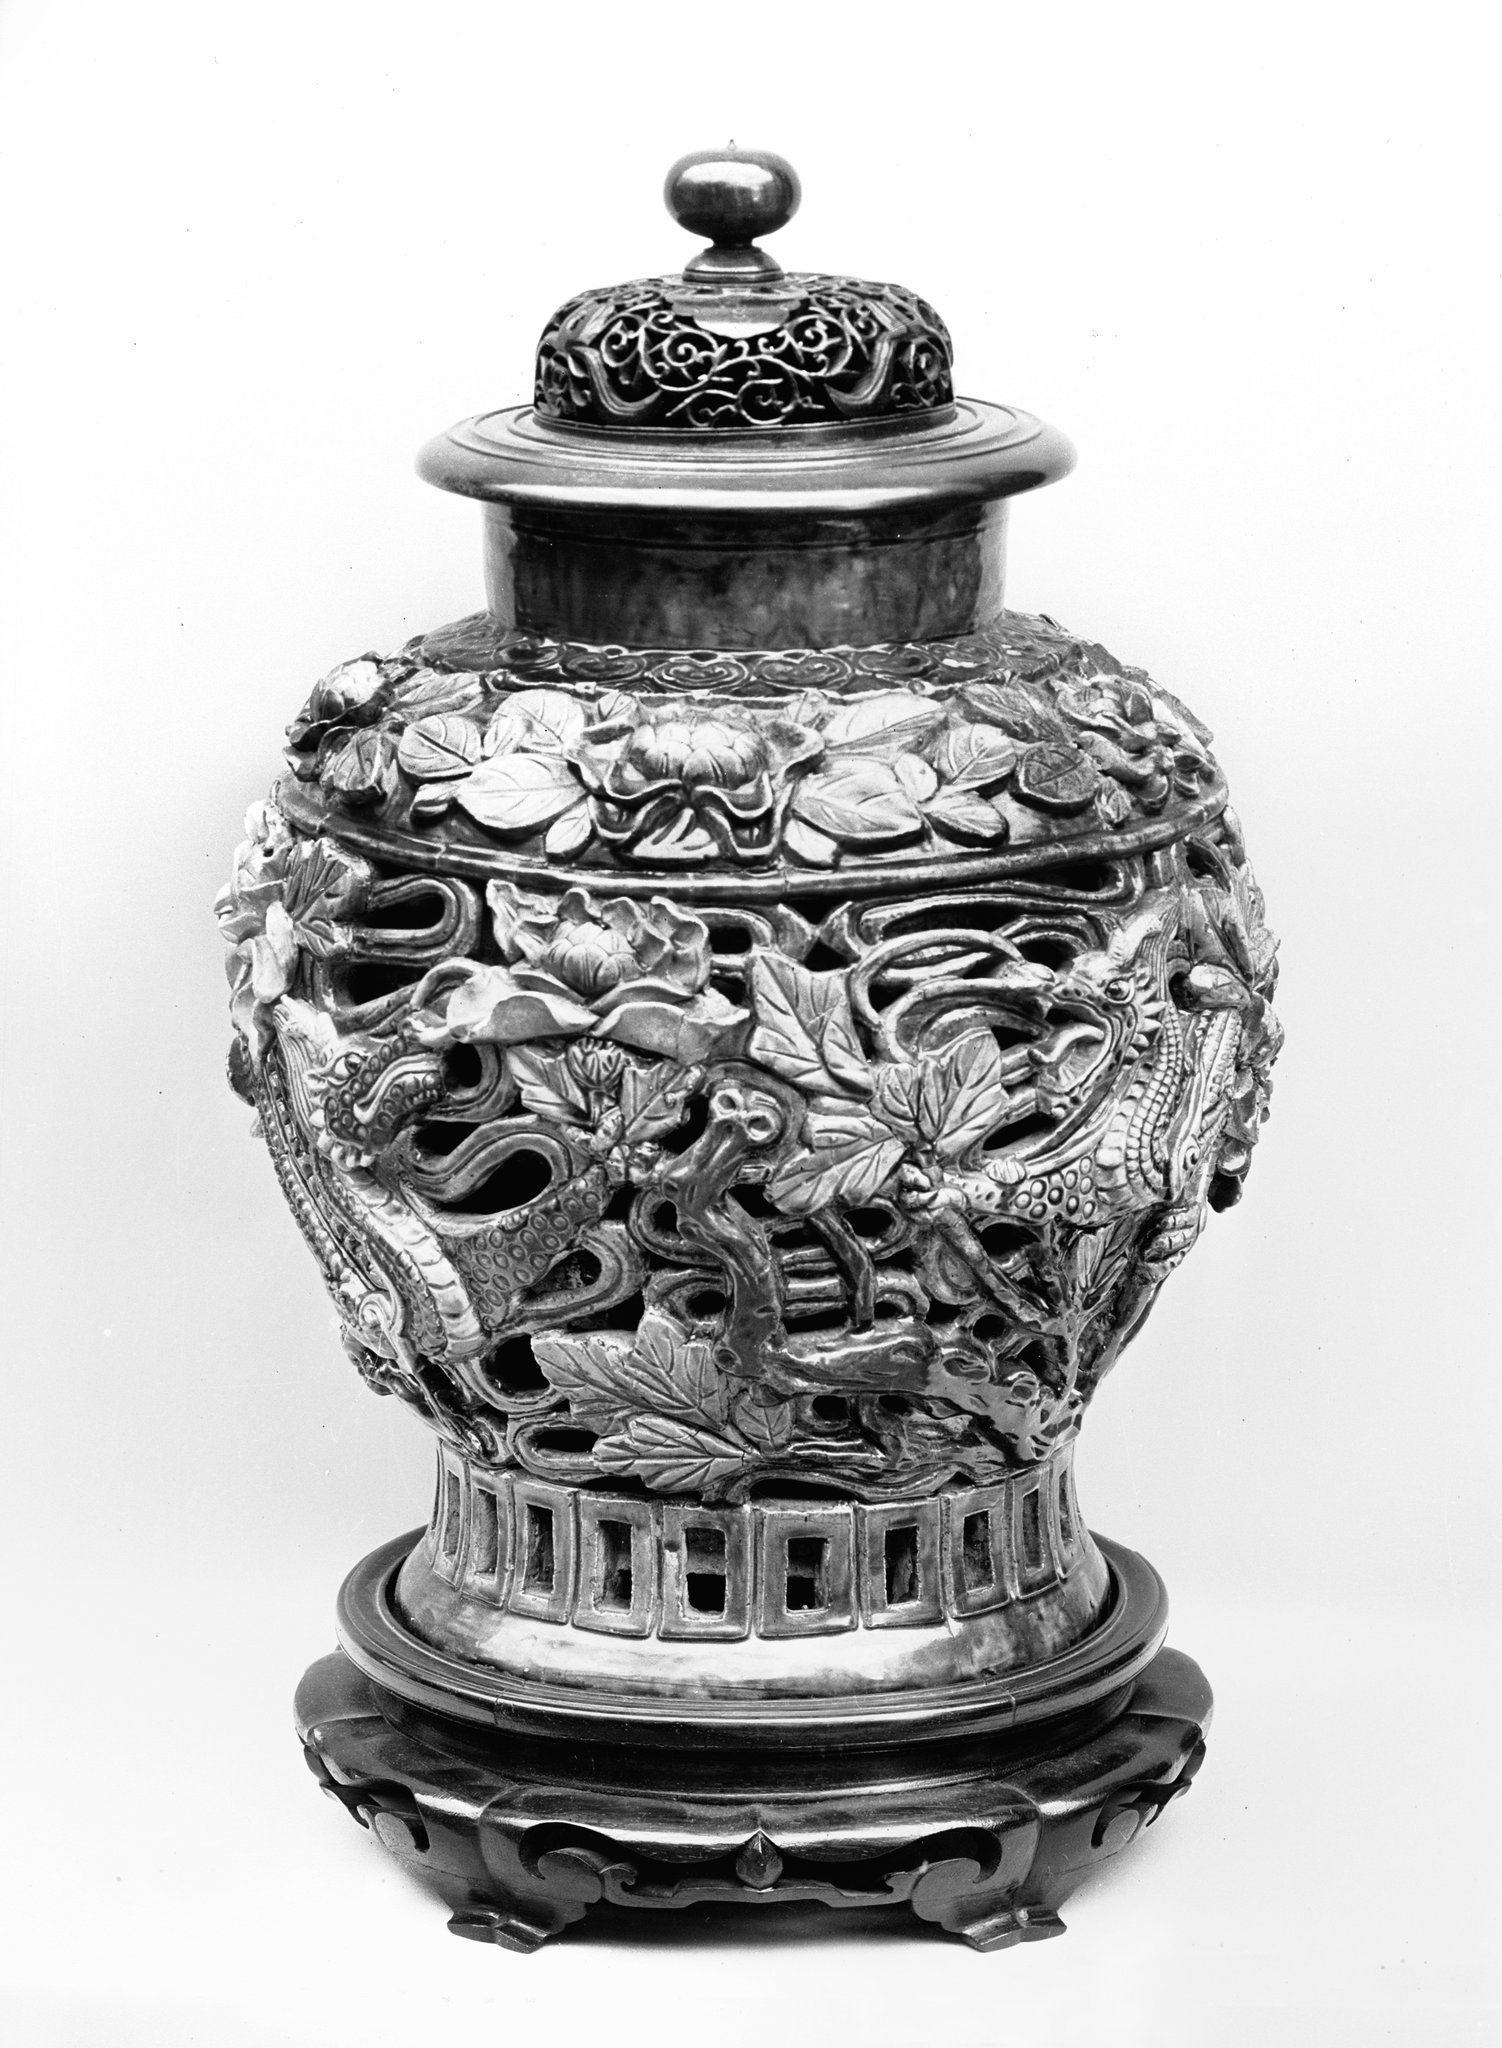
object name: jar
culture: chinese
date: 1368-1644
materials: enamel, pottery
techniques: painting, polychrome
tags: dragons,flowers